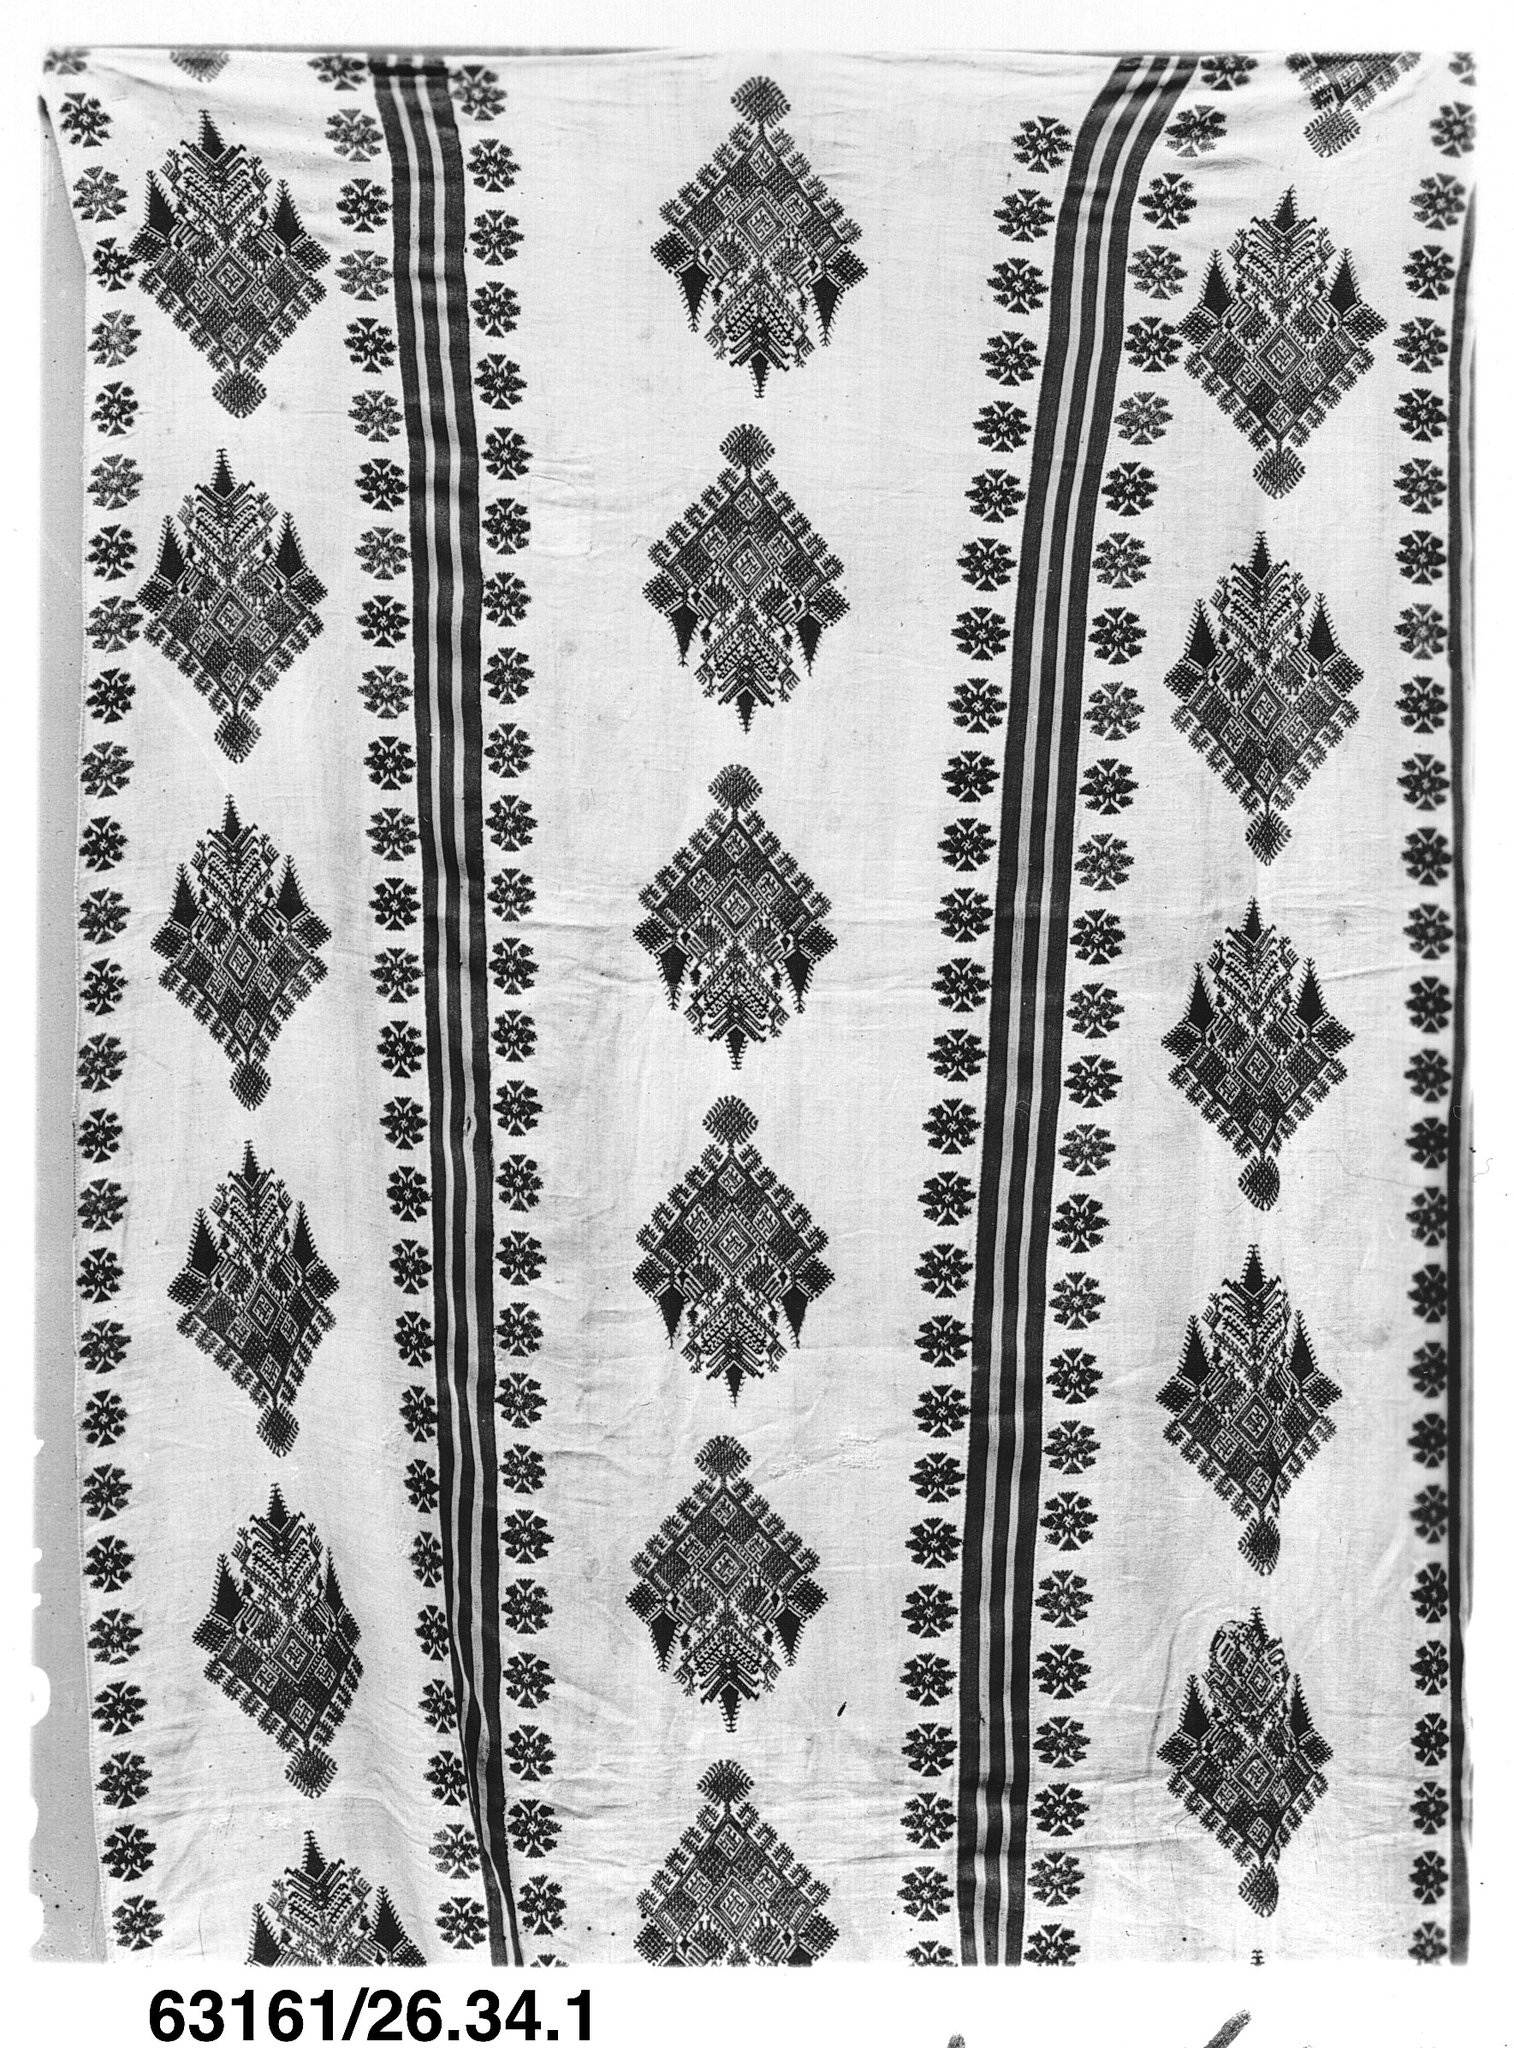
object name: curtain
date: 1701-1800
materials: linen, silk